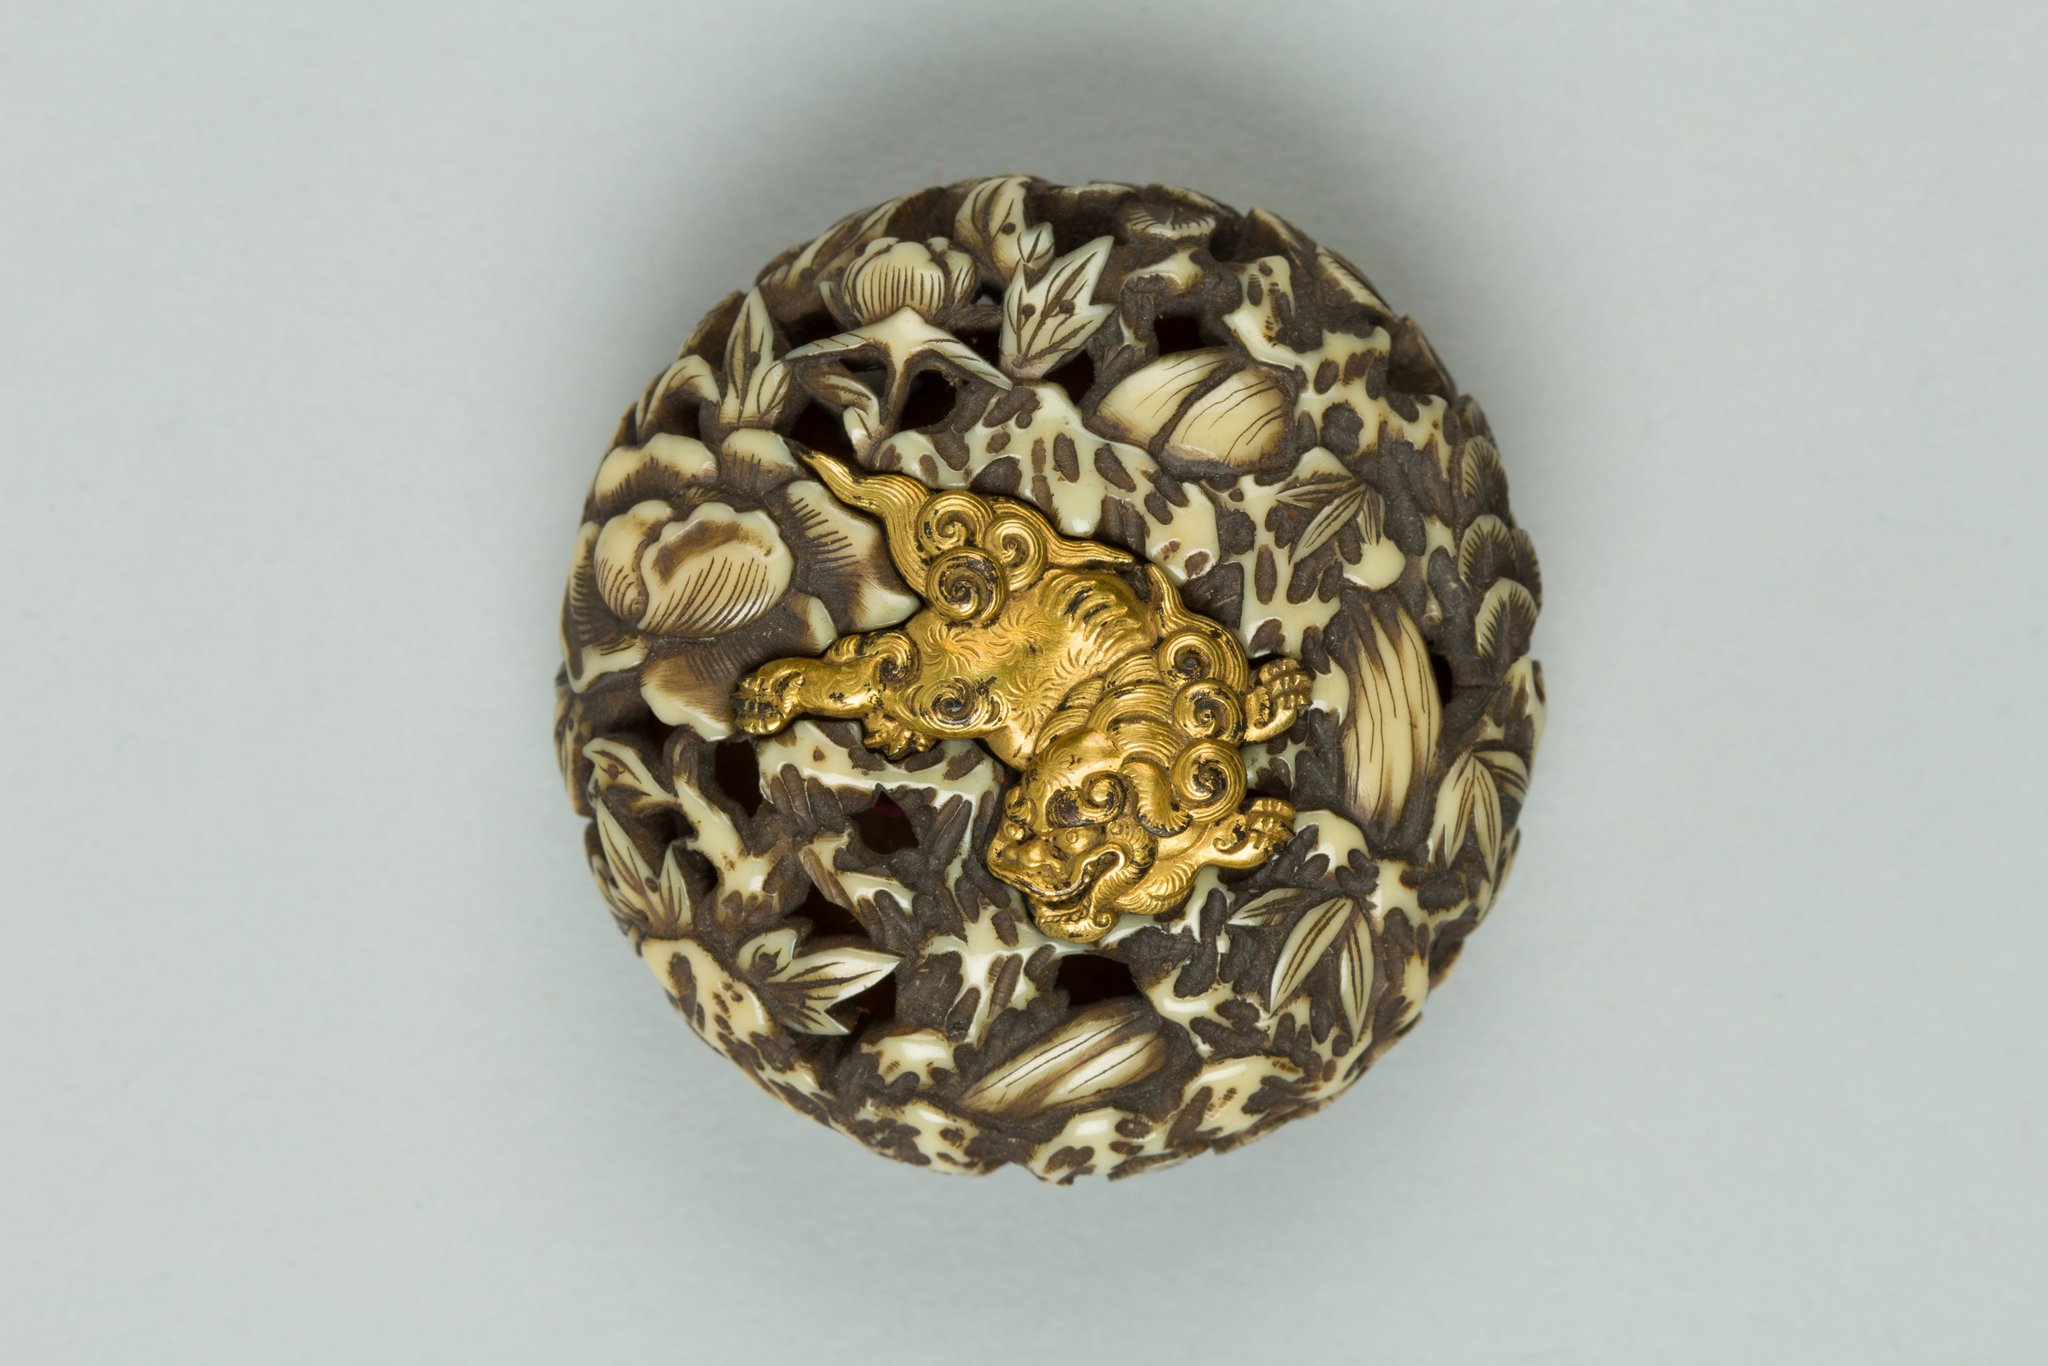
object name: netsuke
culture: japanese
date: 1801-1900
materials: gold, ivory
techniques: carving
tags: lions